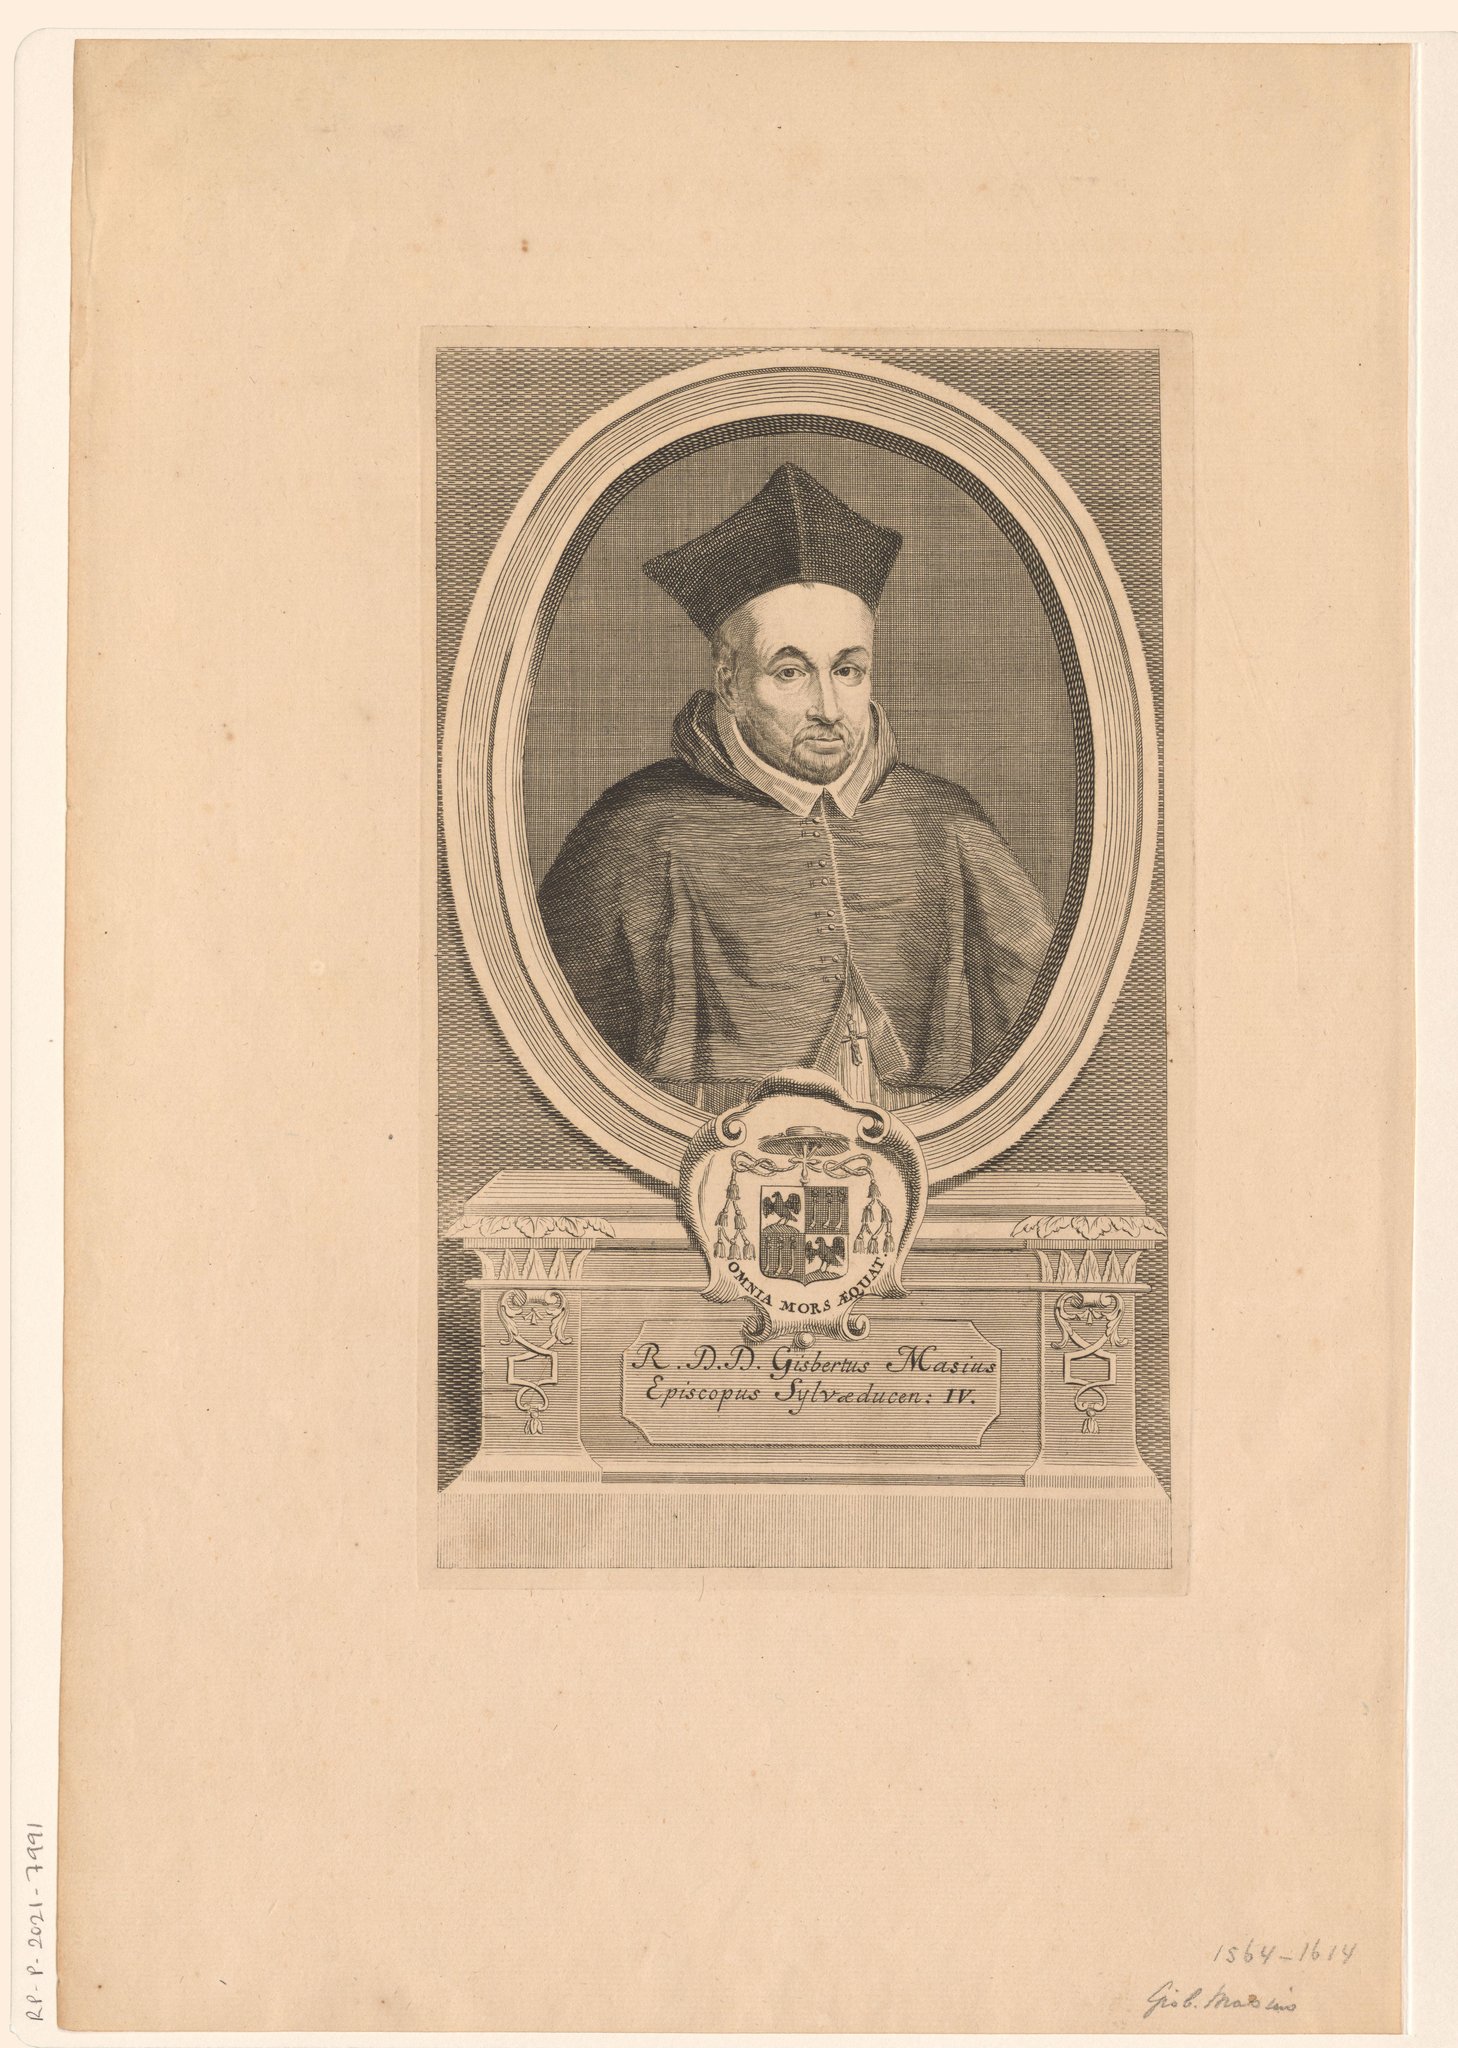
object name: print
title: Portret van Ghisbertus Masius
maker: jan baptist jongelinx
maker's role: print maker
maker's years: 1689-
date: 1725-1734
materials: paper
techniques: engraving, etching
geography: antwerp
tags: den bosch, archbishop, bishop, etc. (roman catholic), ornament ~ medallion, historical persons, armorial bearing, heraldry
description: Prent waarschijnlijk uit: Gestel, Corneille van. Historia sacra et profana archiepiscopatus Mechliniensis (...). Den Haag: Christiaan van Lom, 1725. Of uit: Le Roy, Jacques. Groot kerkelijk tooneel des Hertogdoms van Brabant. Den Haag: Christiaan van Lom, 1727. Of uit de Franse vertaling van 1734.